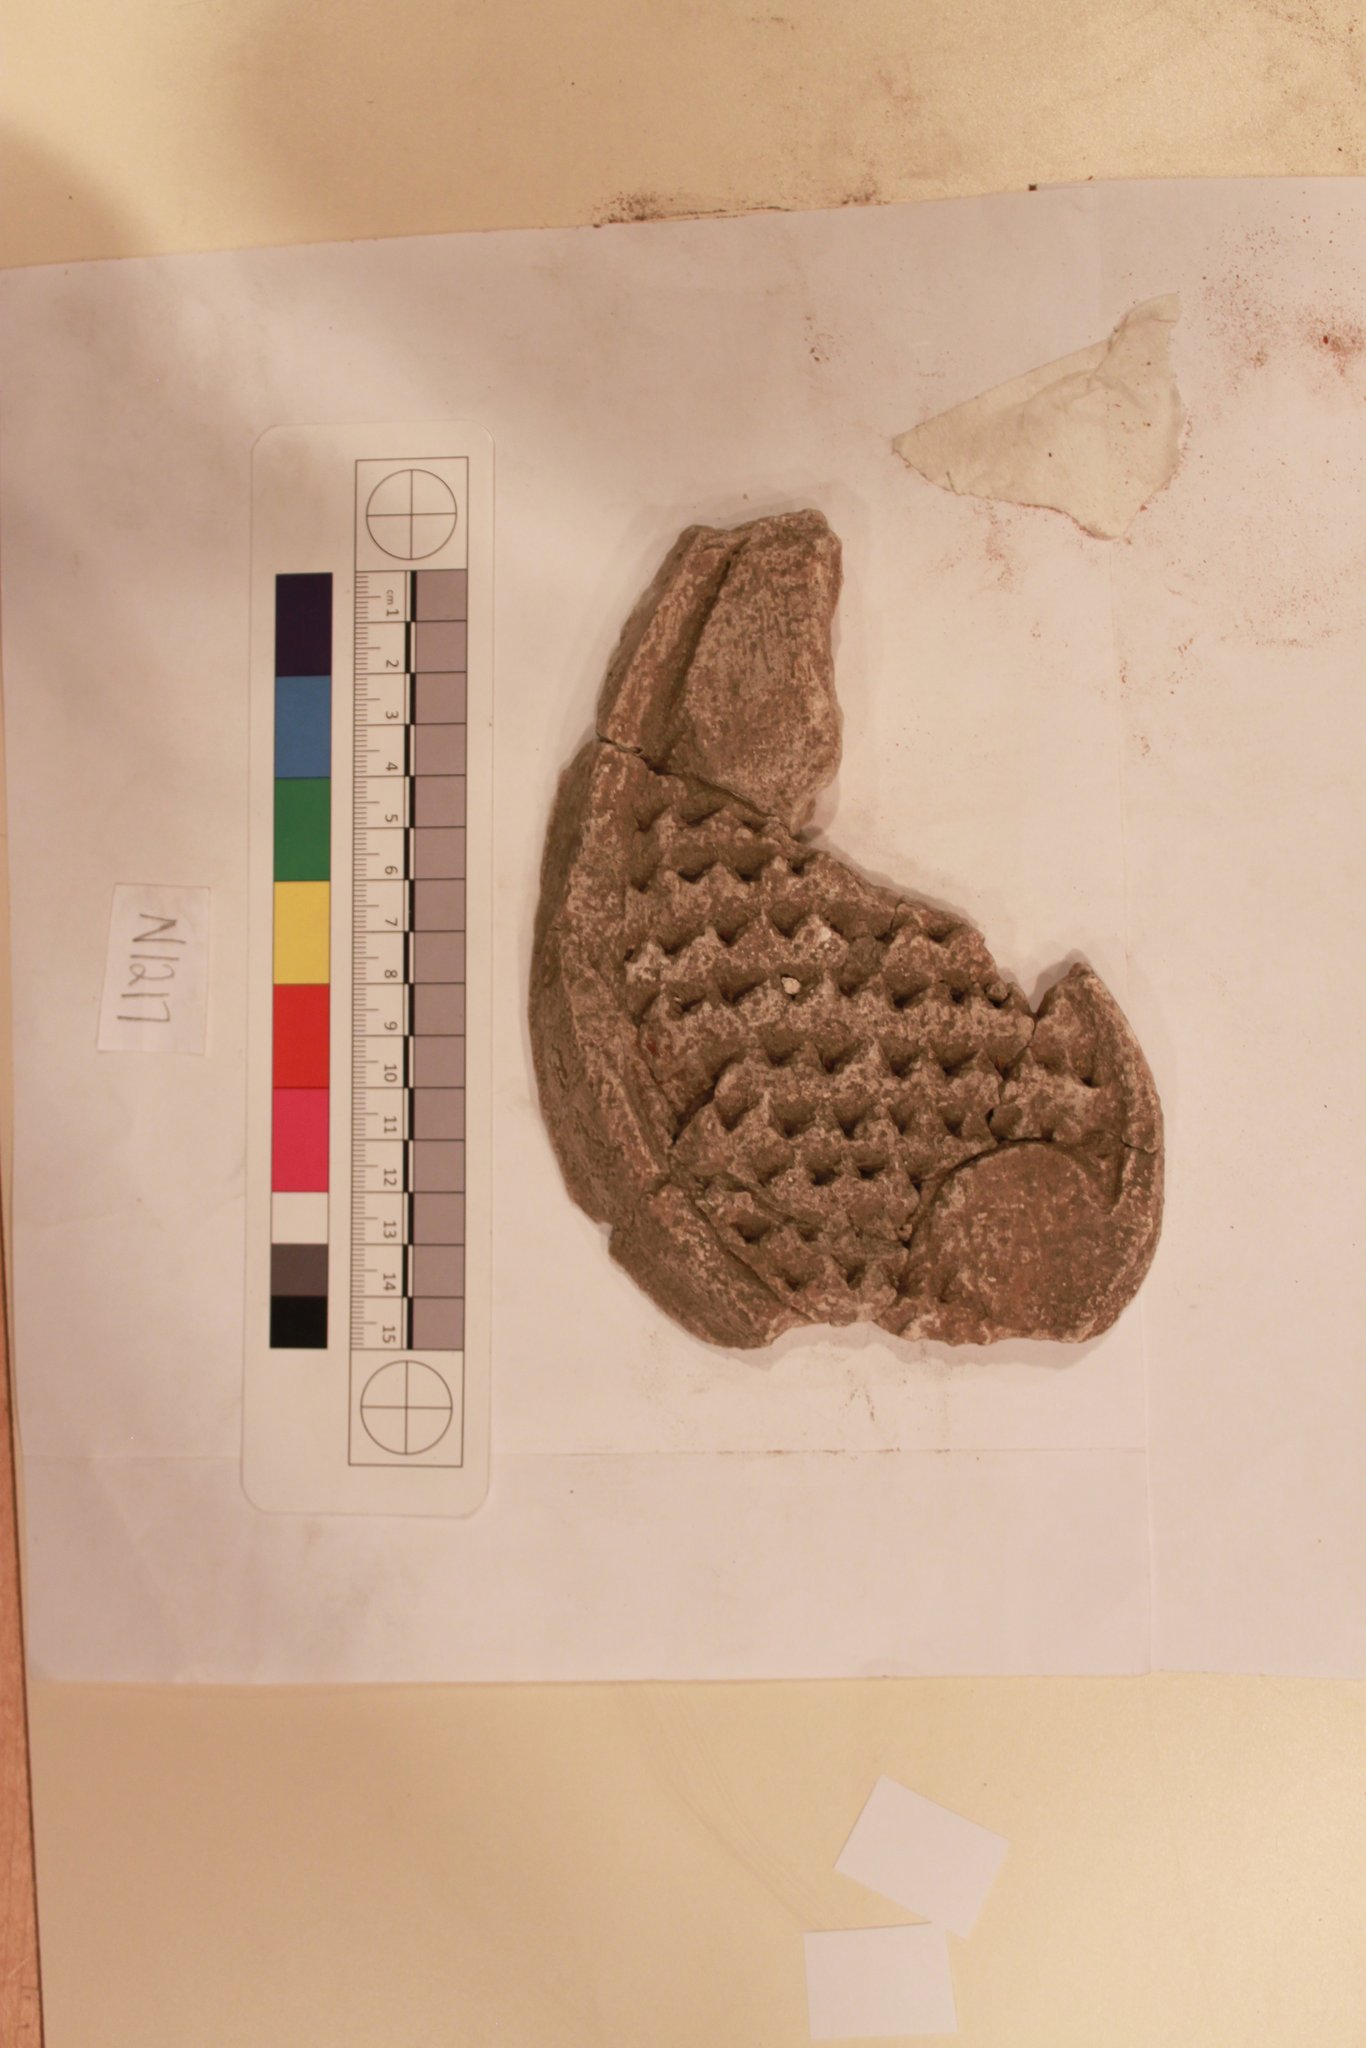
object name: fragment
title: Stucco Fragment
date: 701-1200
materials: plaster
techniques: carving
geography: iran